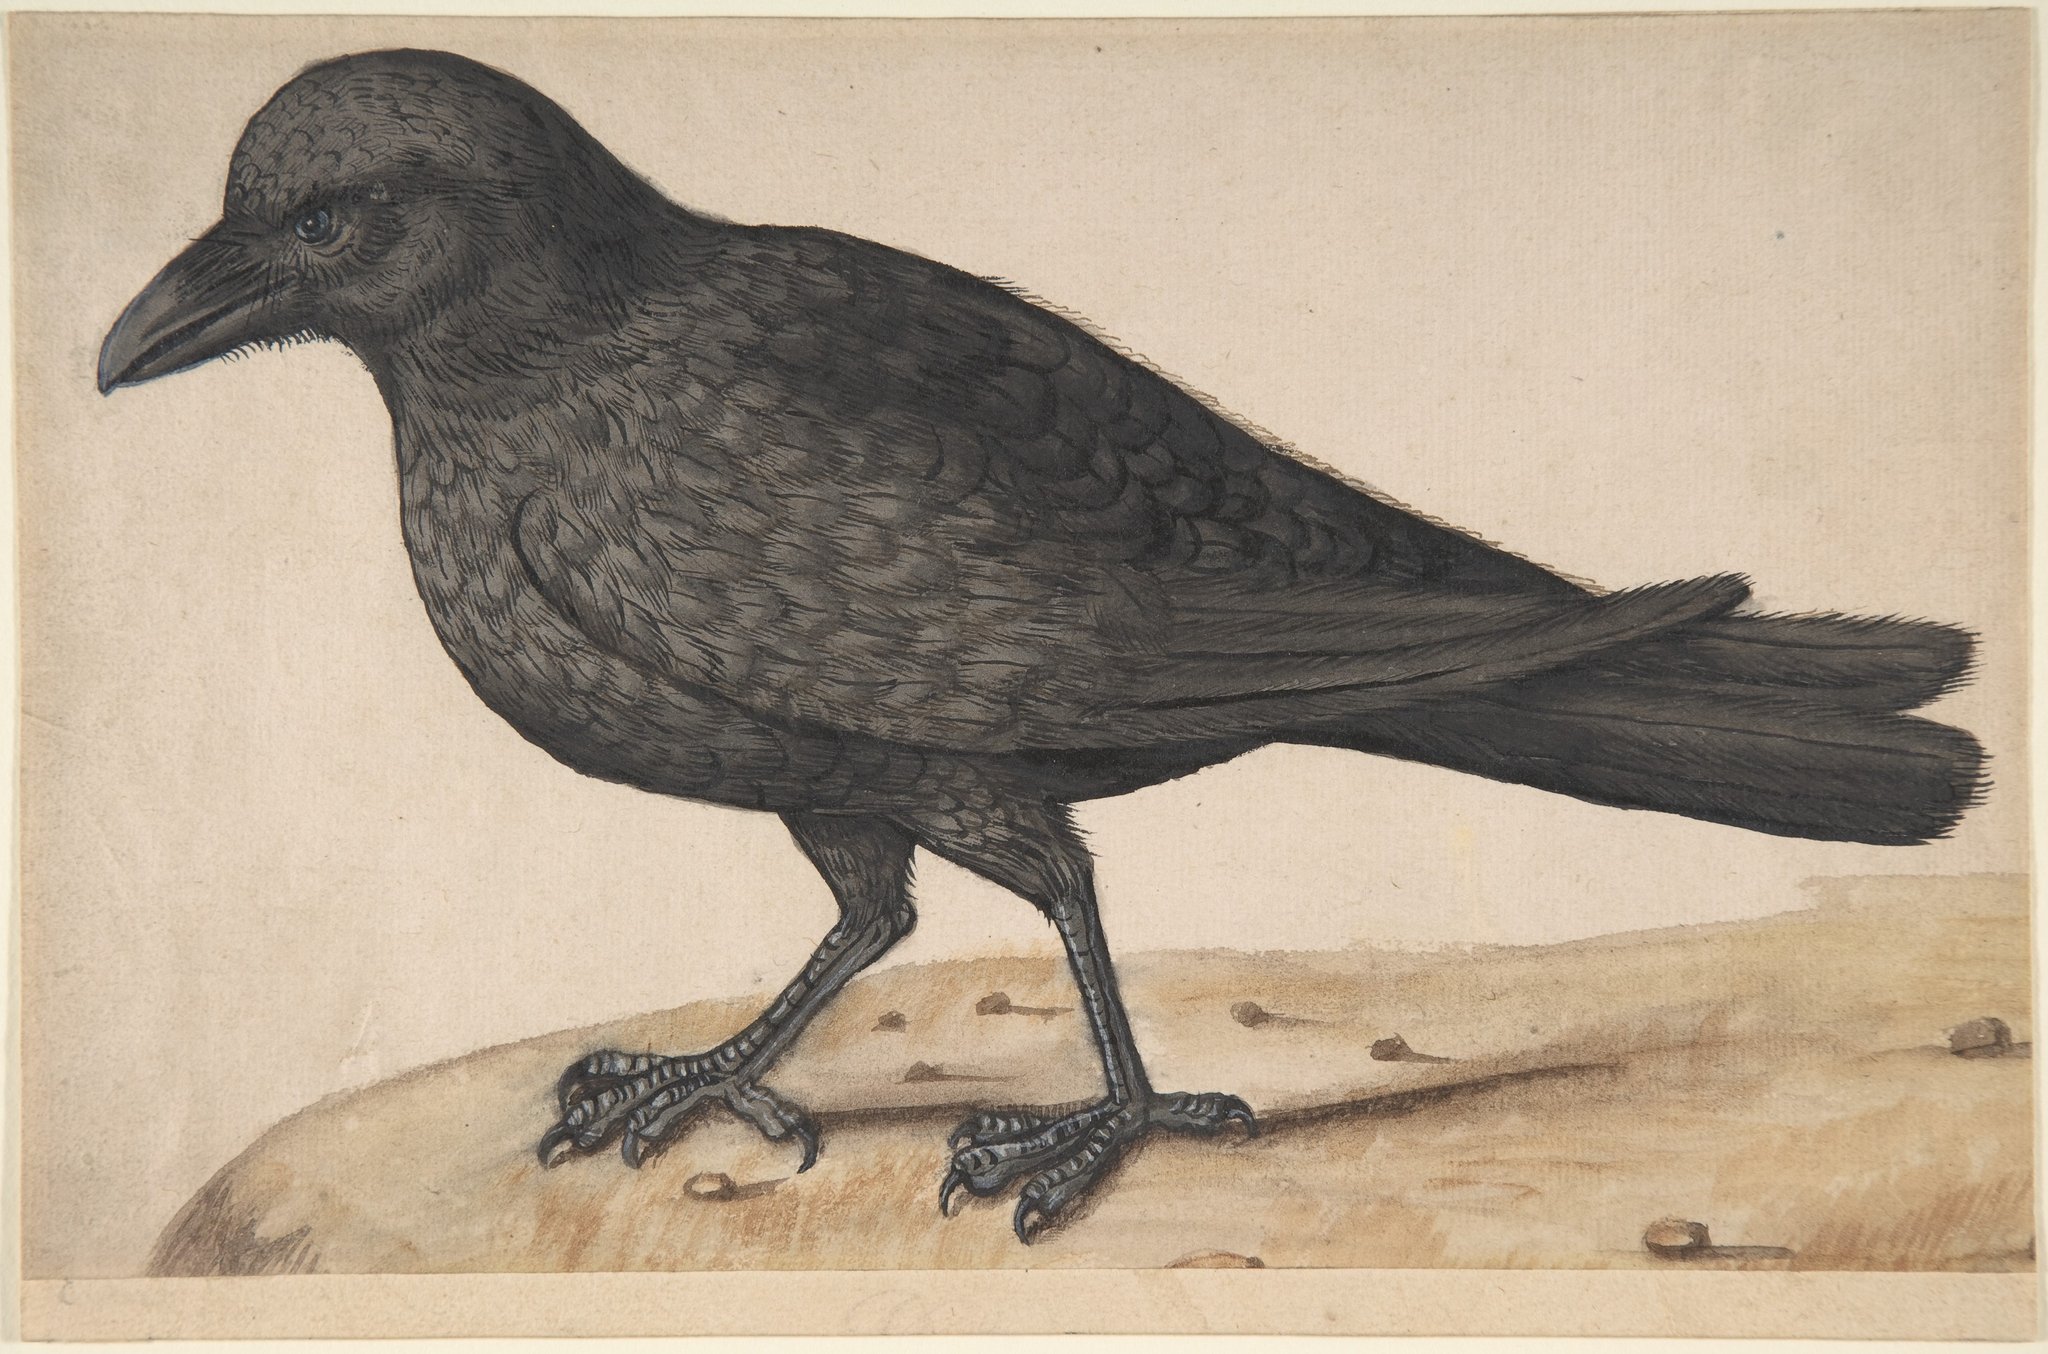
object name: drawing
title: A Crow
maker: anonymous, italian, 17th century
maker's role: artist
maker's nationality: italian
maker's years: 1600-1700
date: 1600-1700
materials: watercolor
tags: birds